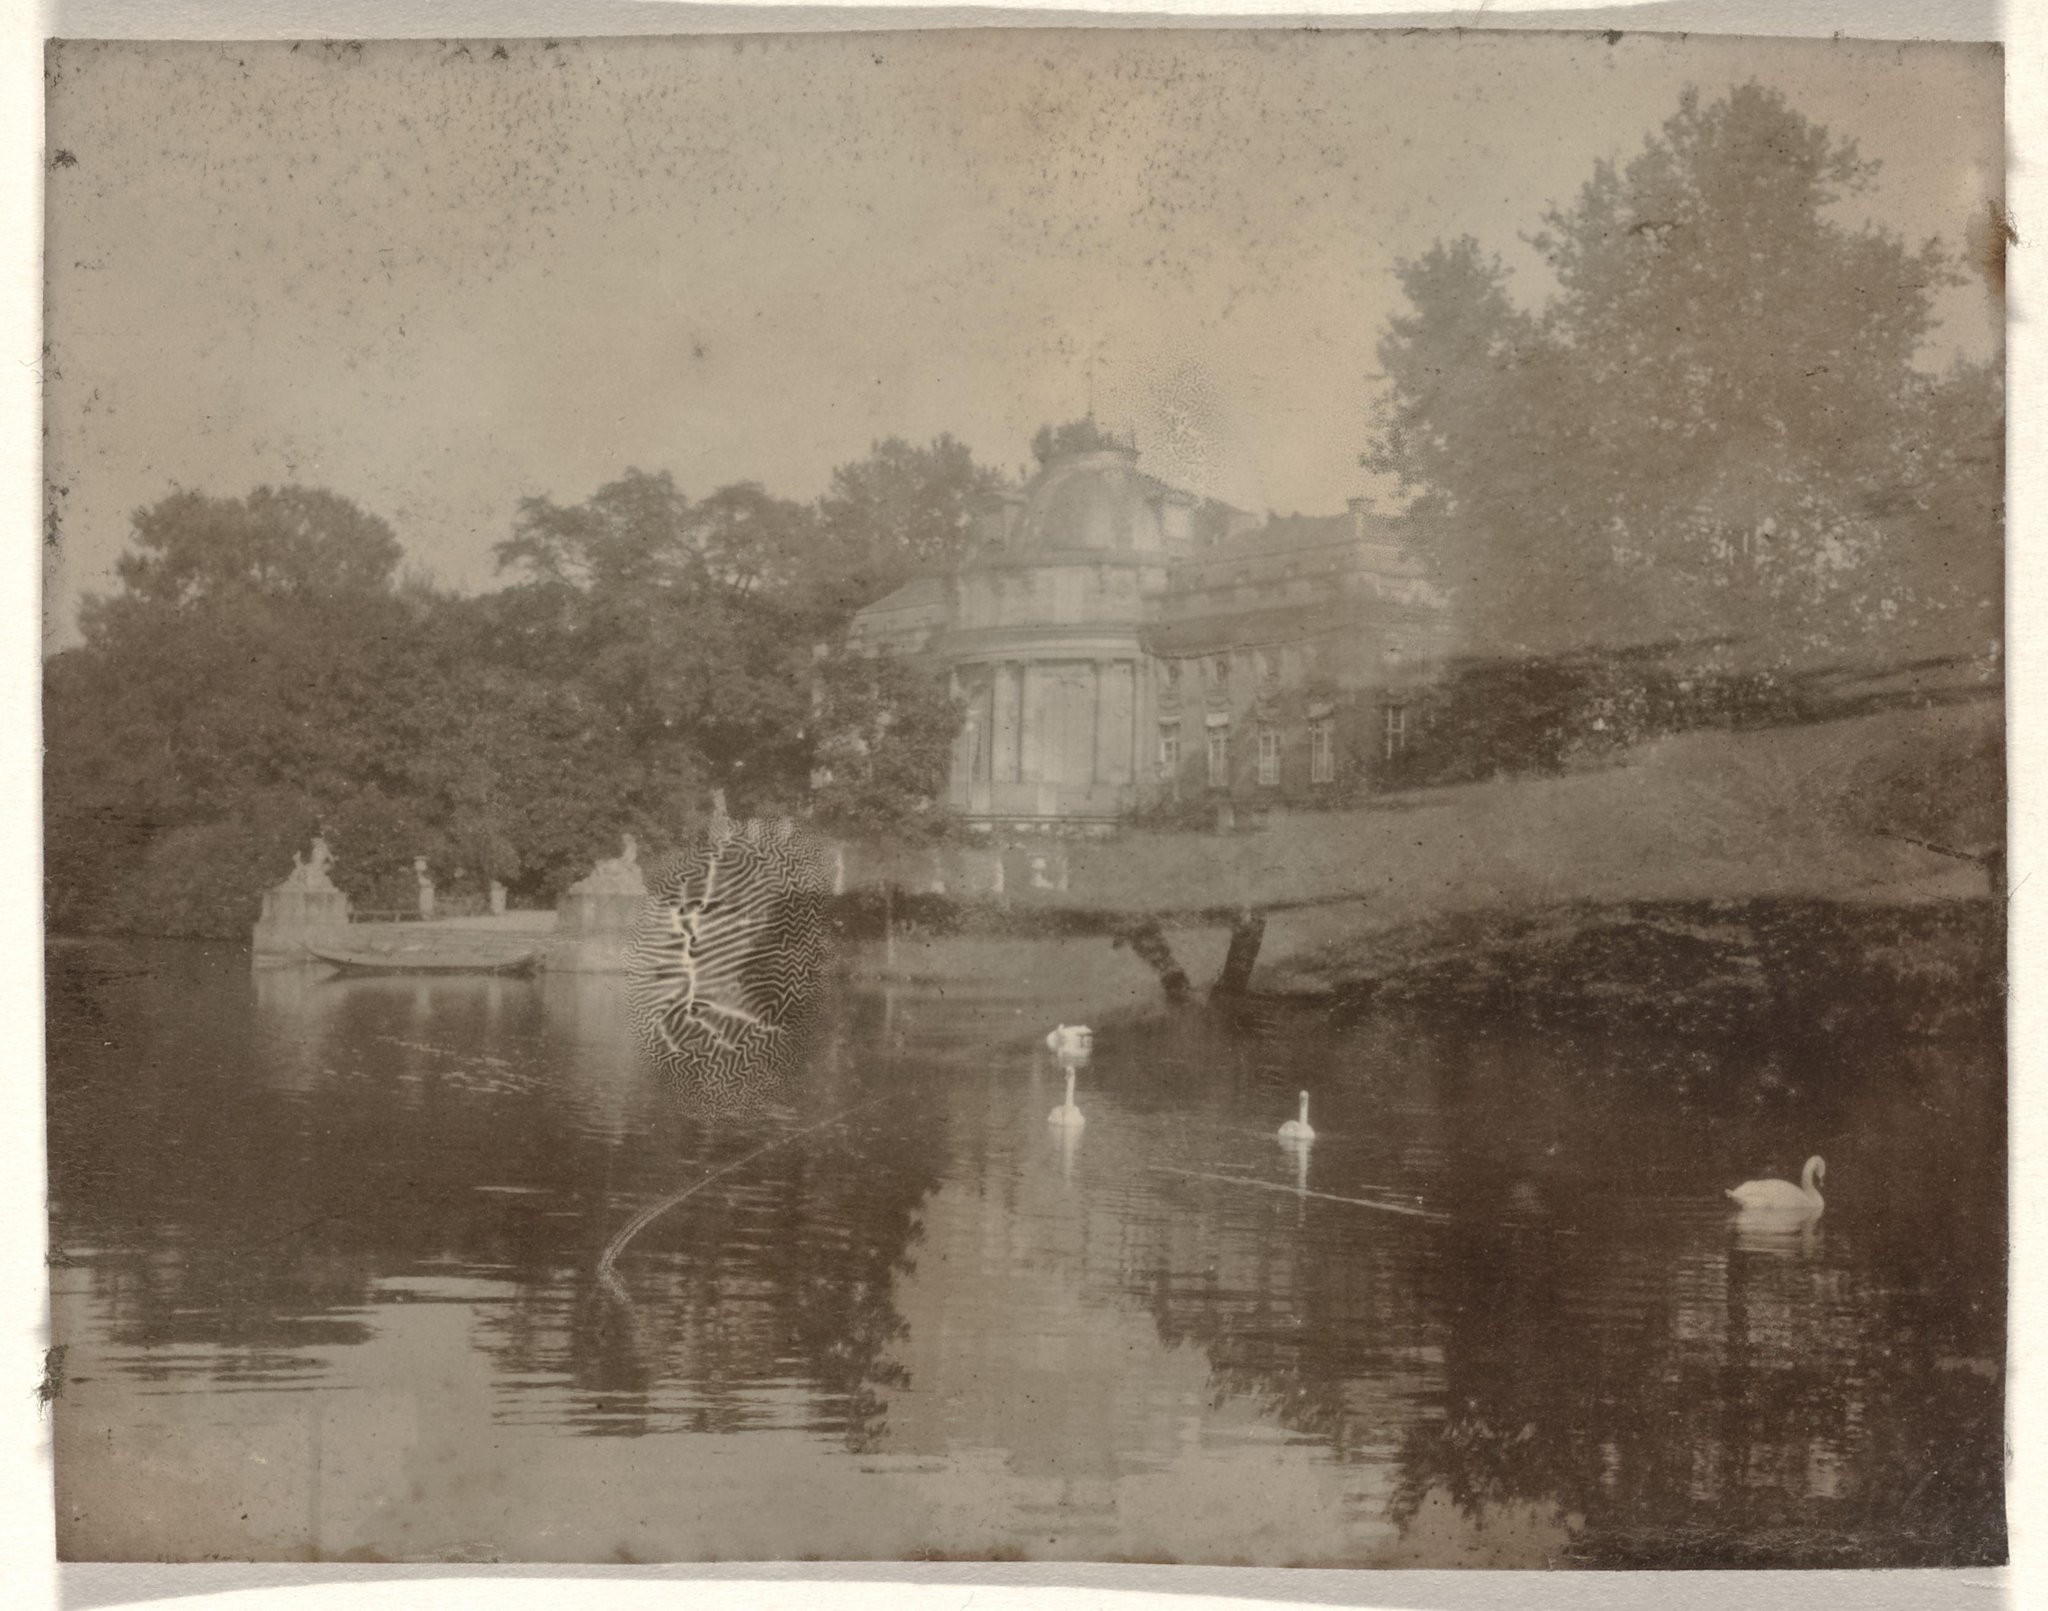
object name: photograph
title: Landhuis aan de oever van een water waarin zwanen zwemmen, met bomen op de achtergrond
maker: Anonymous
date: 1900-1950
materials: photographic support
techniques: gelatin silver print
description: Landhuis aan de oever van een water waarin zwanen zwemmen, met bomen op de achtergrond.